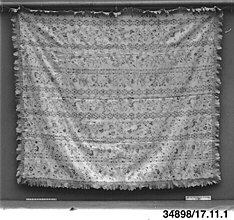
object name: bedspread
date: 1788-1790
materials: silk